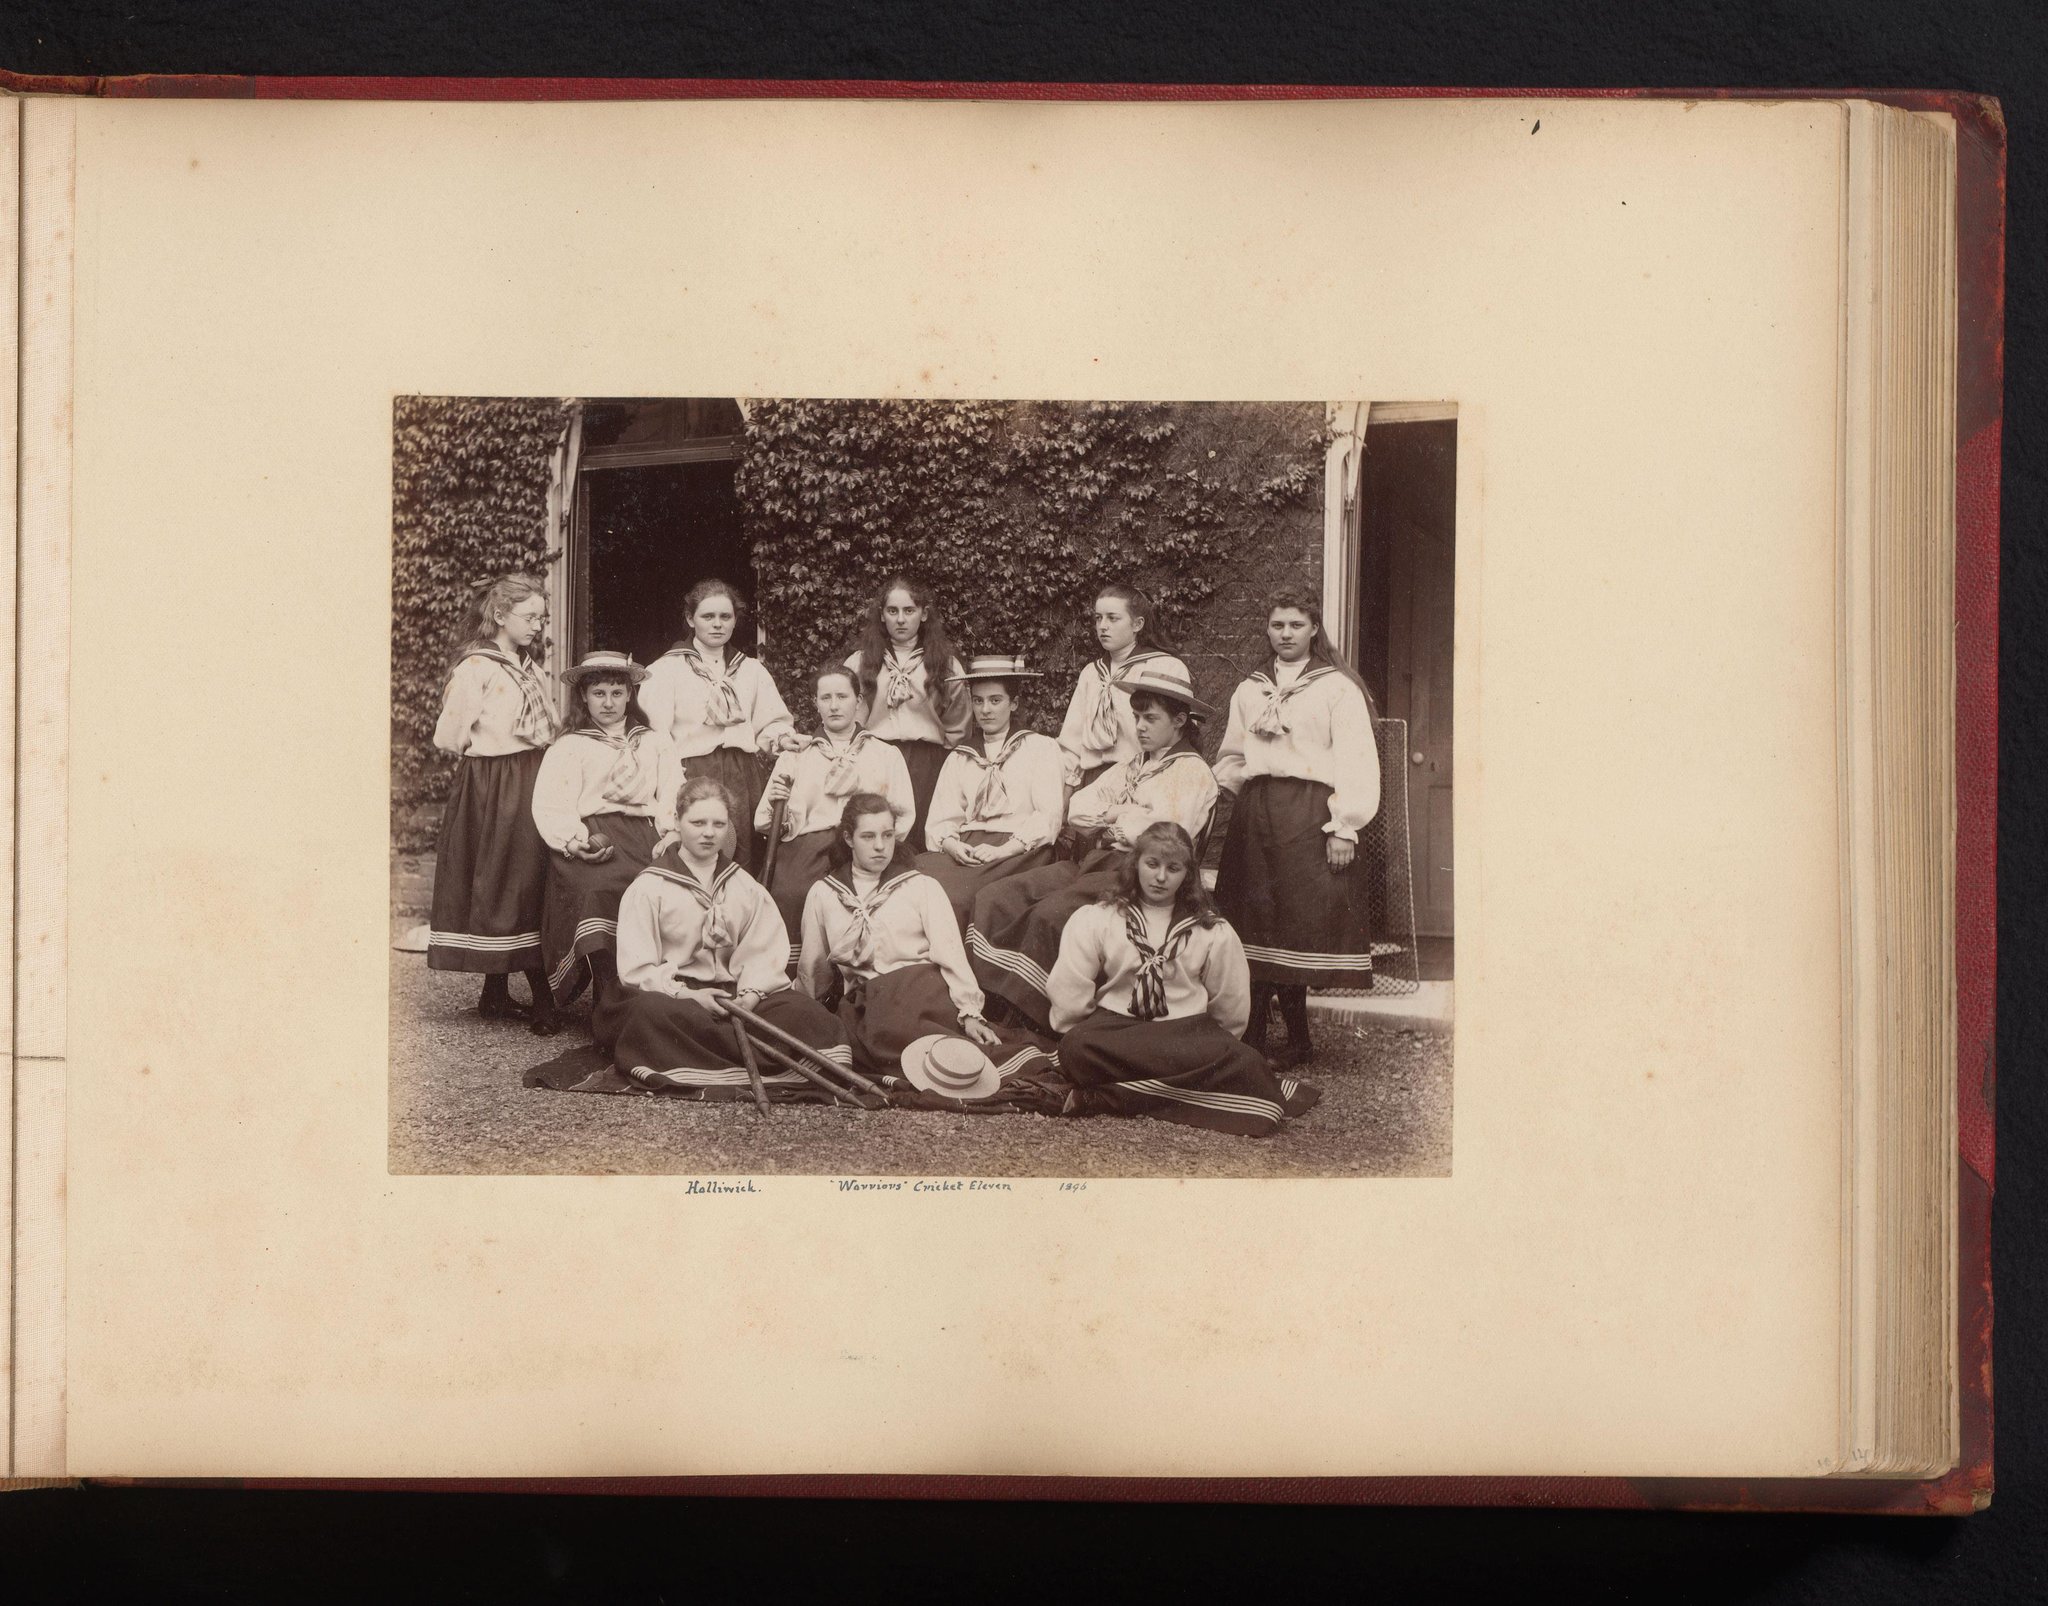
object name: album leaf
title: Groepsportret met twaalf jonge vrouwen uit het cricketteam van de Halliwick School for Girls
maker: Anonymous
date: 1896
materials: cardboard, photographic support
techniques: albumen print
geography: london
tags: anonymous historical persons portrayed in a group, in a group-portrait - bb - woman, cricket (ball game)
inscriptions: annotation: ‘Halliwick. 'Warriors' Cricket Eleven. 1896.’